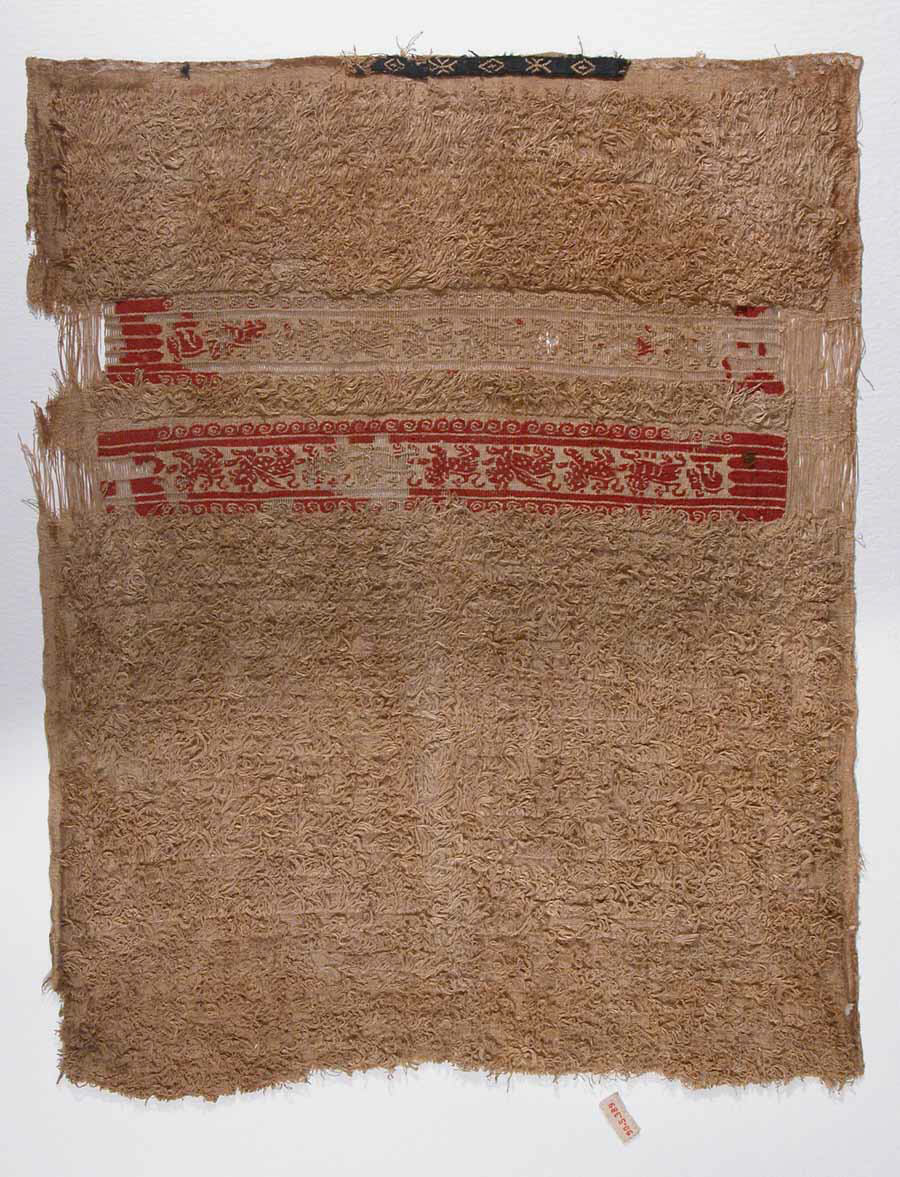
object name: textile fragment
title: Fragment of a Sleeve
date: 301-400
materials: linen, wool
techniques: weave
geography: egypt